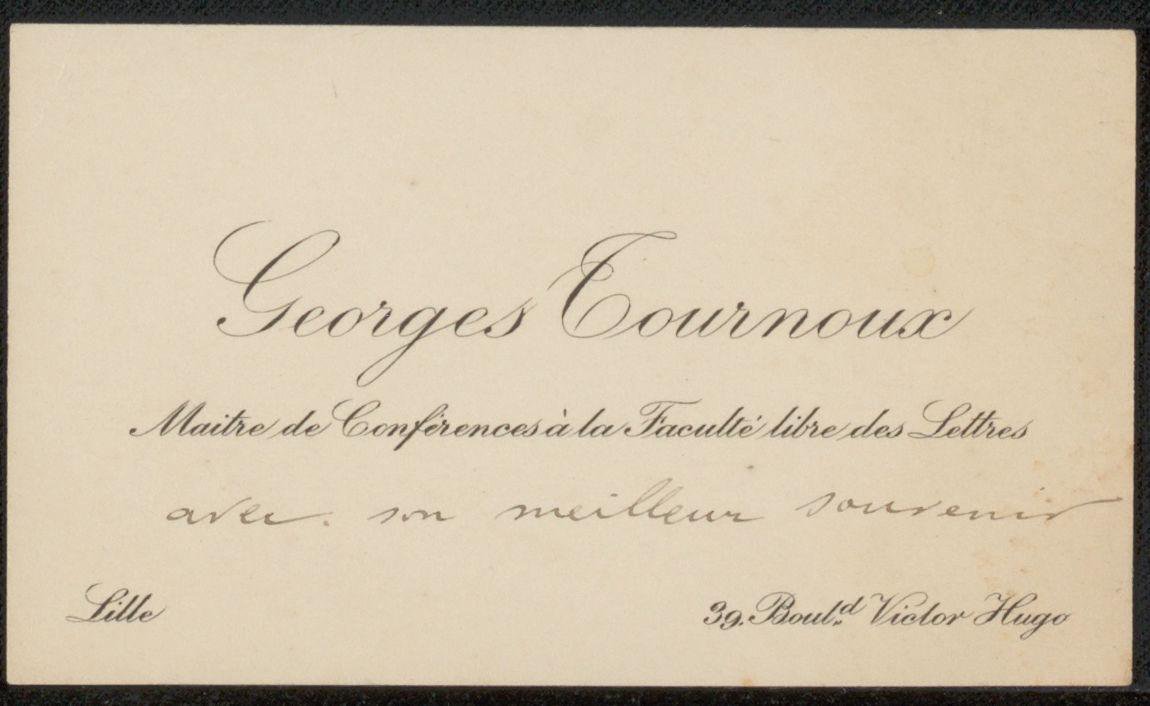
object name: visiting card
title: Visitekaartje aan Philip Zilcken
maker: georges a. tournoux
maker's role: professor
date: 1867-1930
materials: cardboard, ink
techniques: pen, printing, writing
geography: lille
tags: the hague, painter, philip zilcken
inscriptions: collector's mark: ‘RPK’